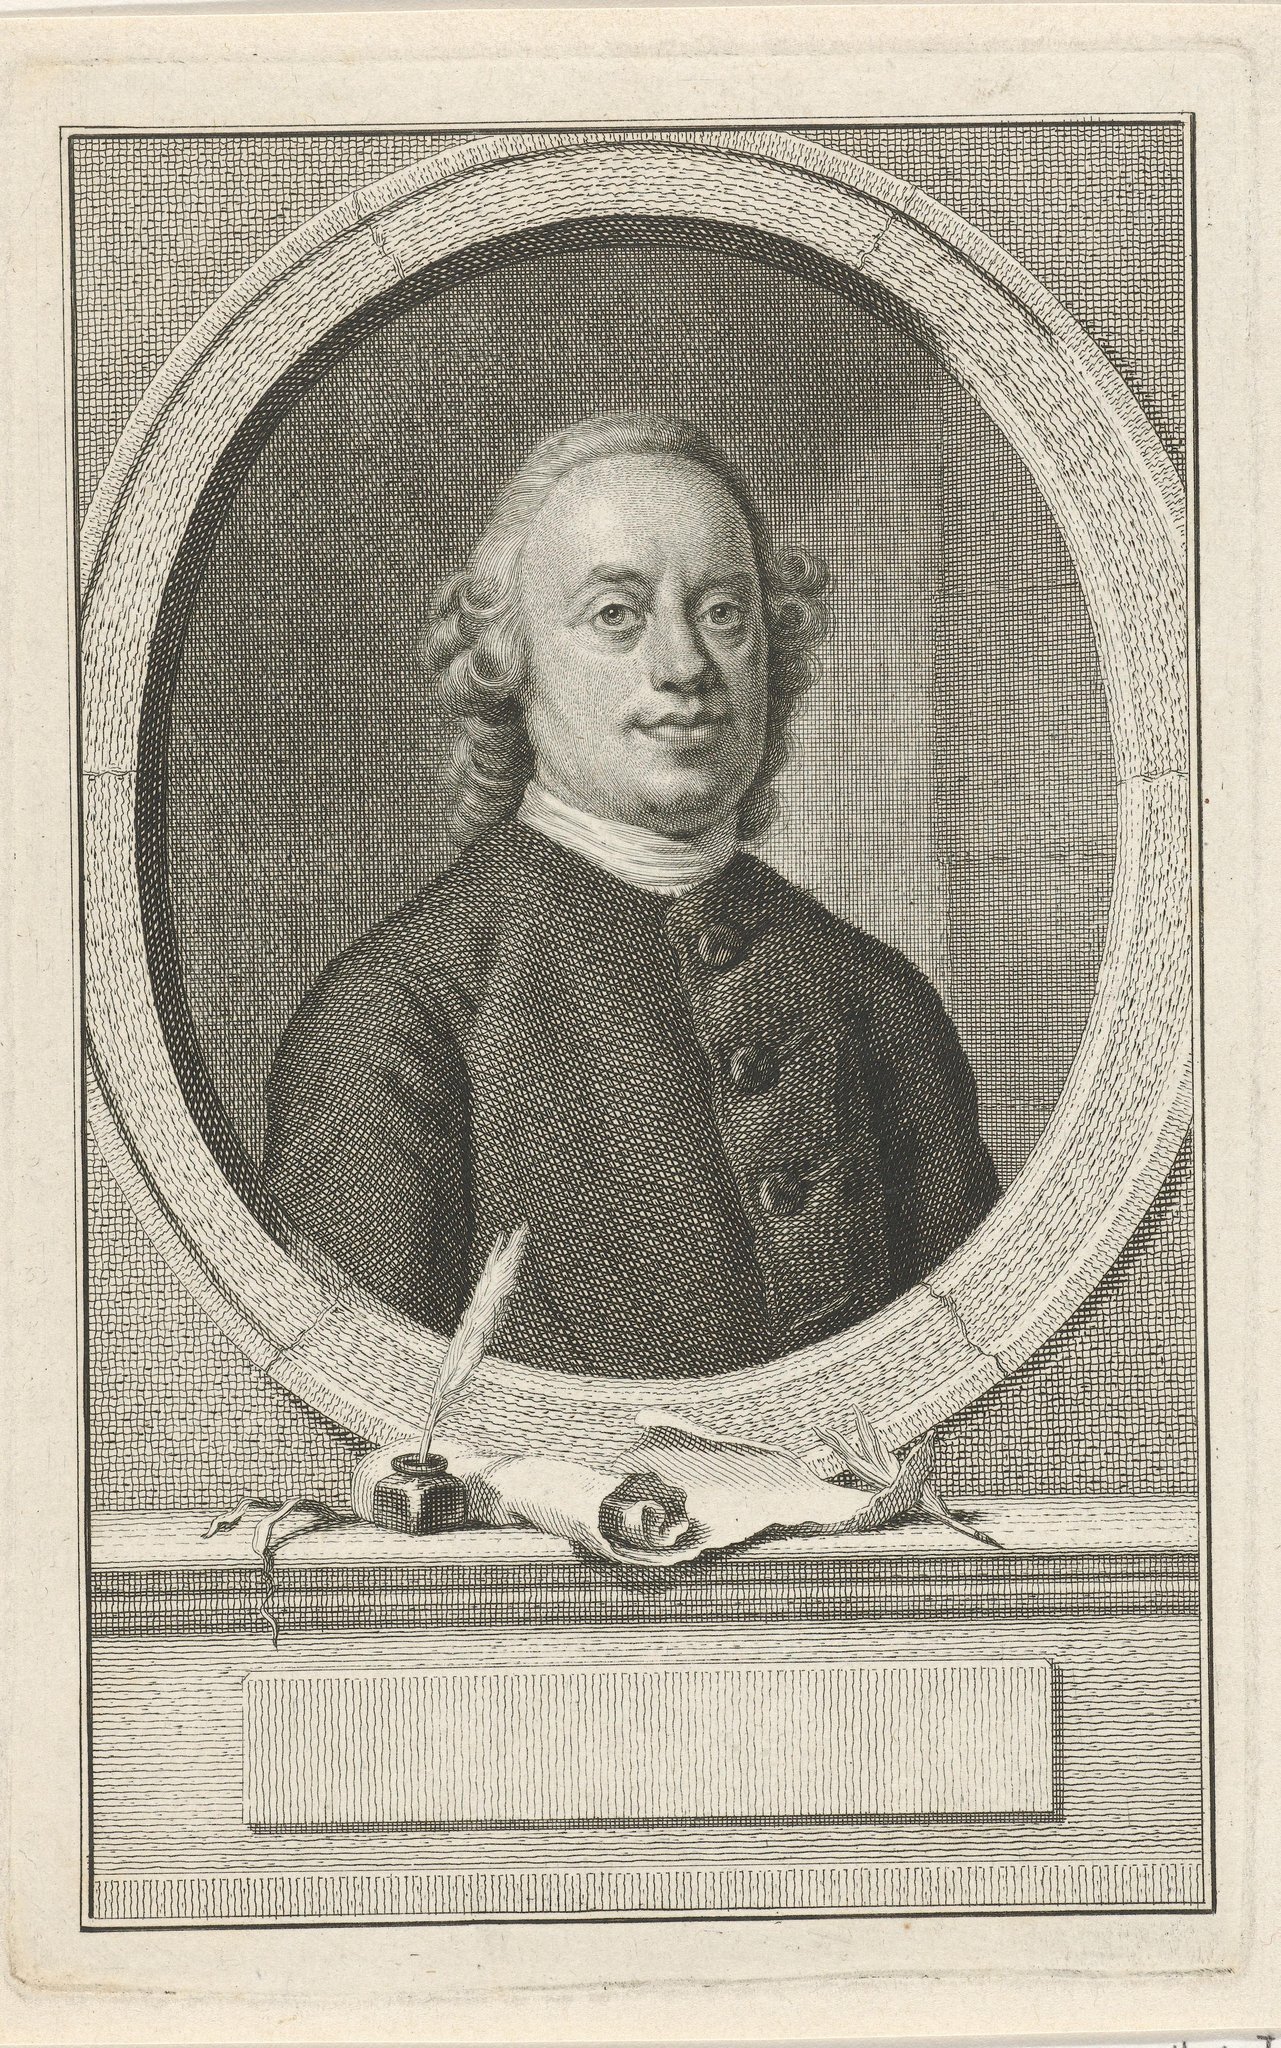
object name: print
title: Portret van Christiaan Salomo Duijtsch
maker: jacob houbraken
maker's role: draughtsman, print maker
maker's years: 1698-1780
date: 1767-1769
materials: paper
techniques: engraving, etching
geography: amsterdam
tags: writing accessories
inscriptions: collector's mark: Lugt 2228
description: Buste naar rechts van Christiaan Salomo Duijtsch in een ovaal. Het portret rust op een plint waarop papier en schrijfgerei. Op de plint een leeg veld voor zijn naam.